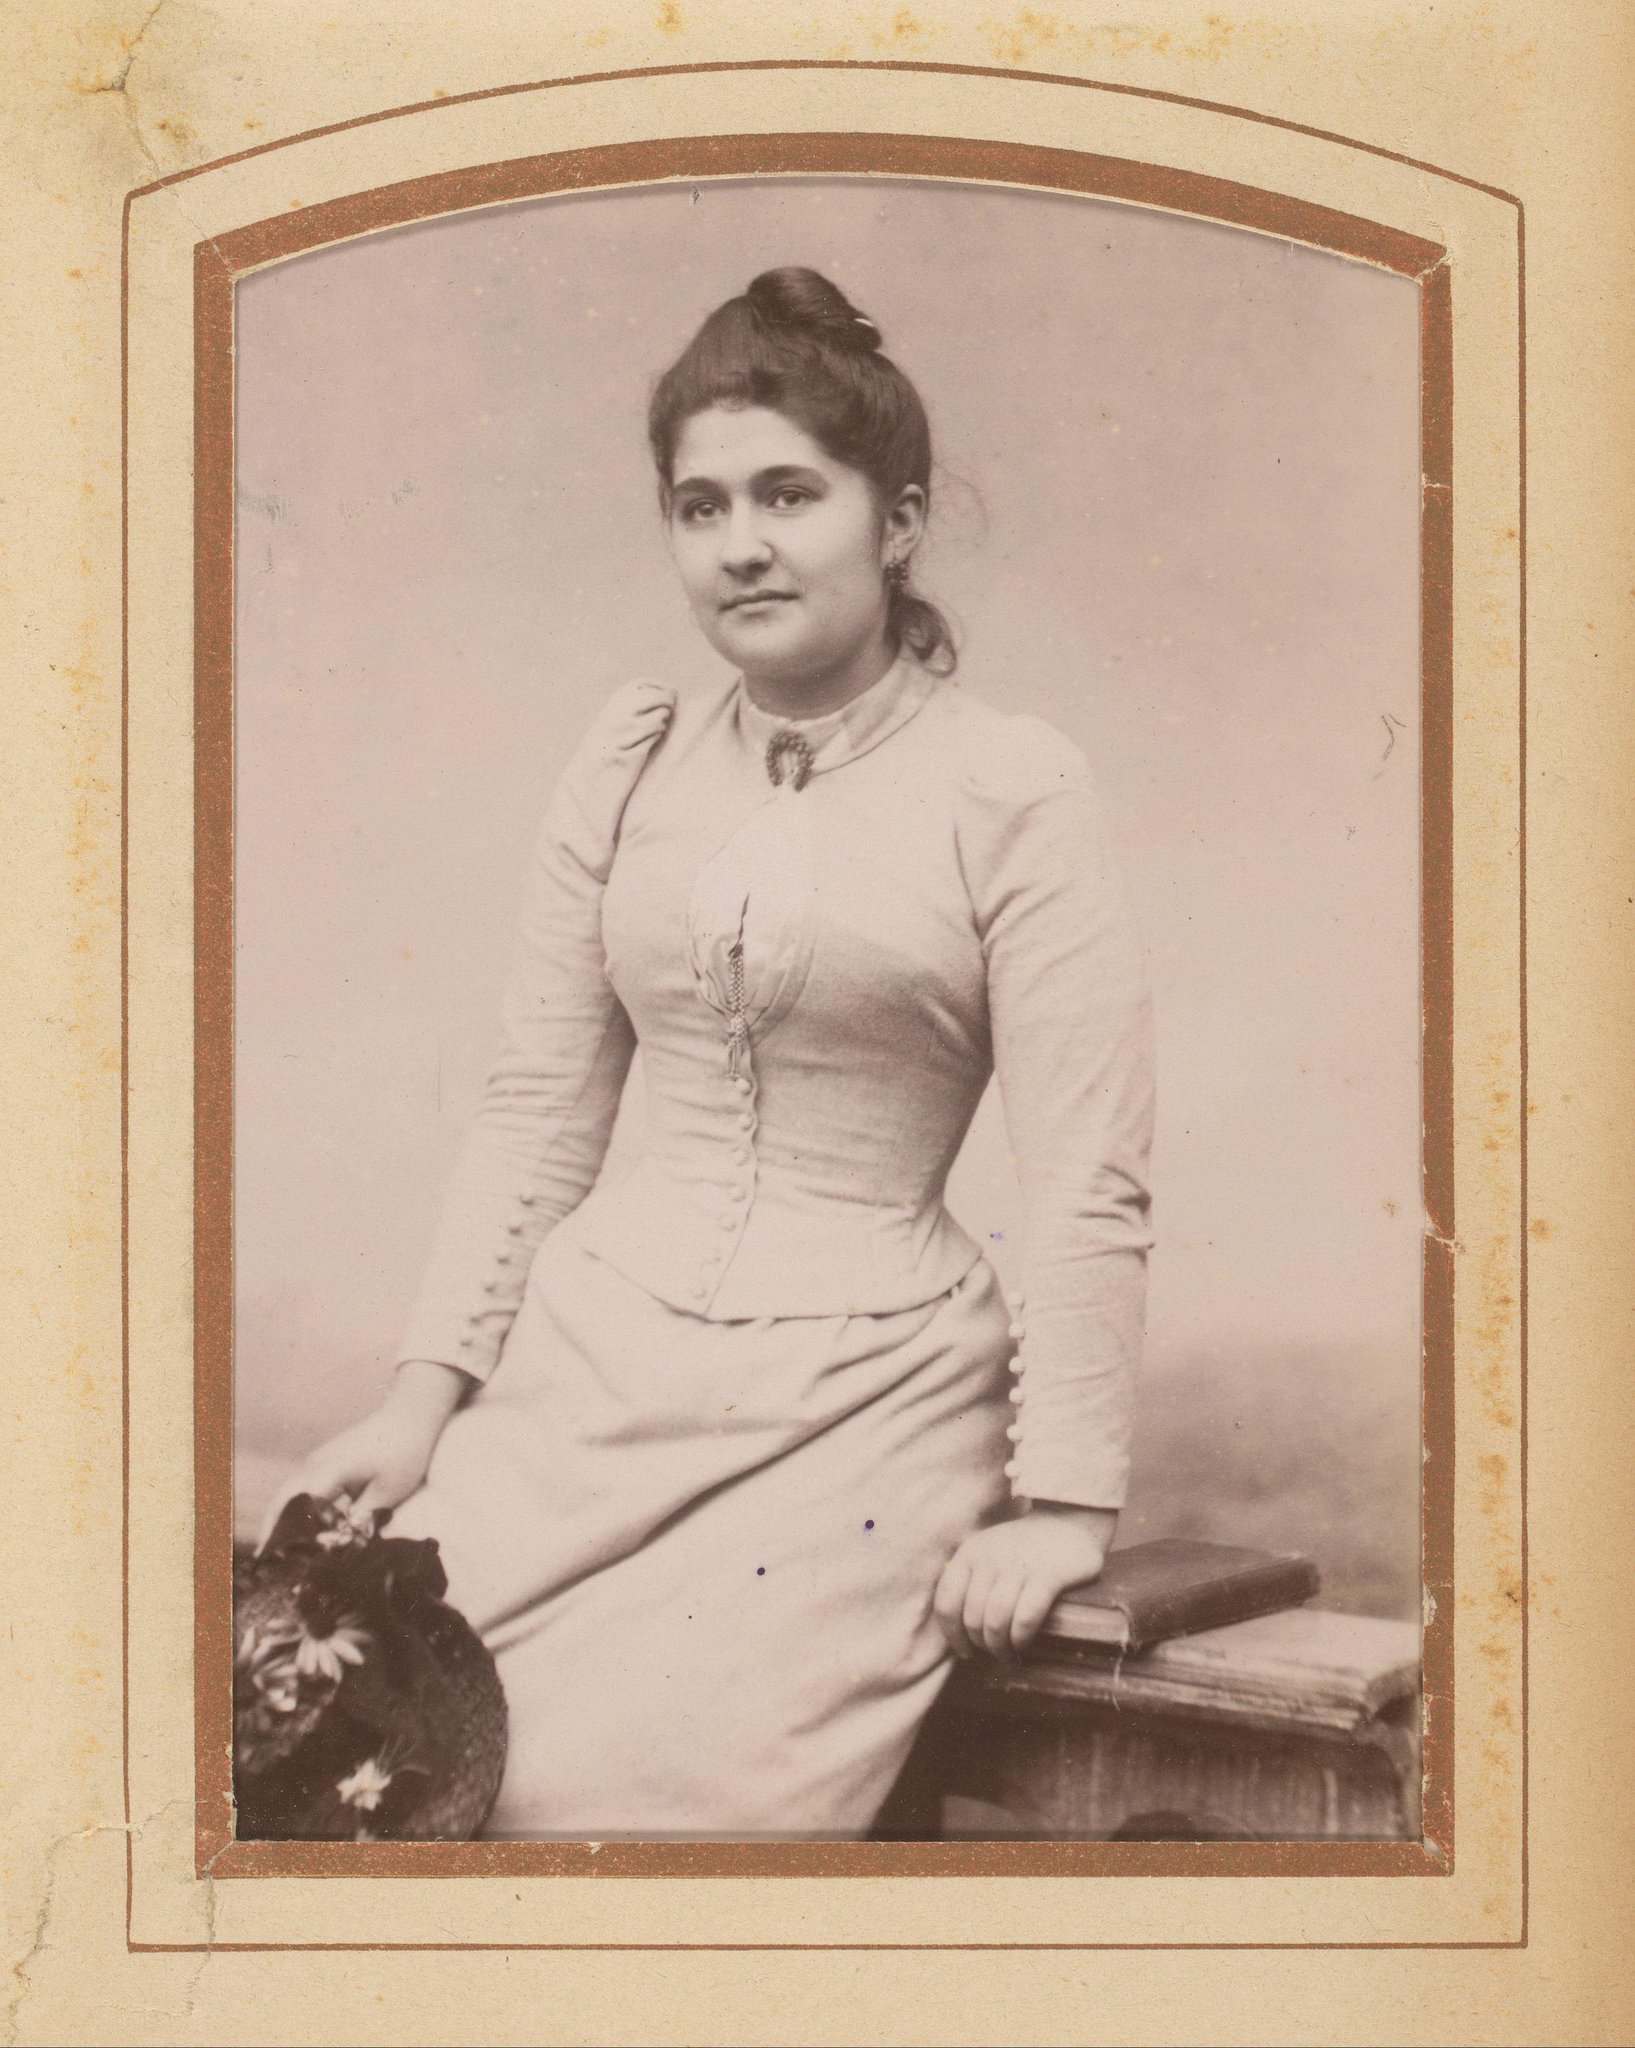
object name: cabinet photograph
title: Portret van een jonge vrouw met hoed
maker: Anonymous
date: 1880-1910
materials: cardboard, photographic support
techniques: collodion silver print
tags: adolescent, young woman, maiden, historical persons - bb - woman, head-gear: hat